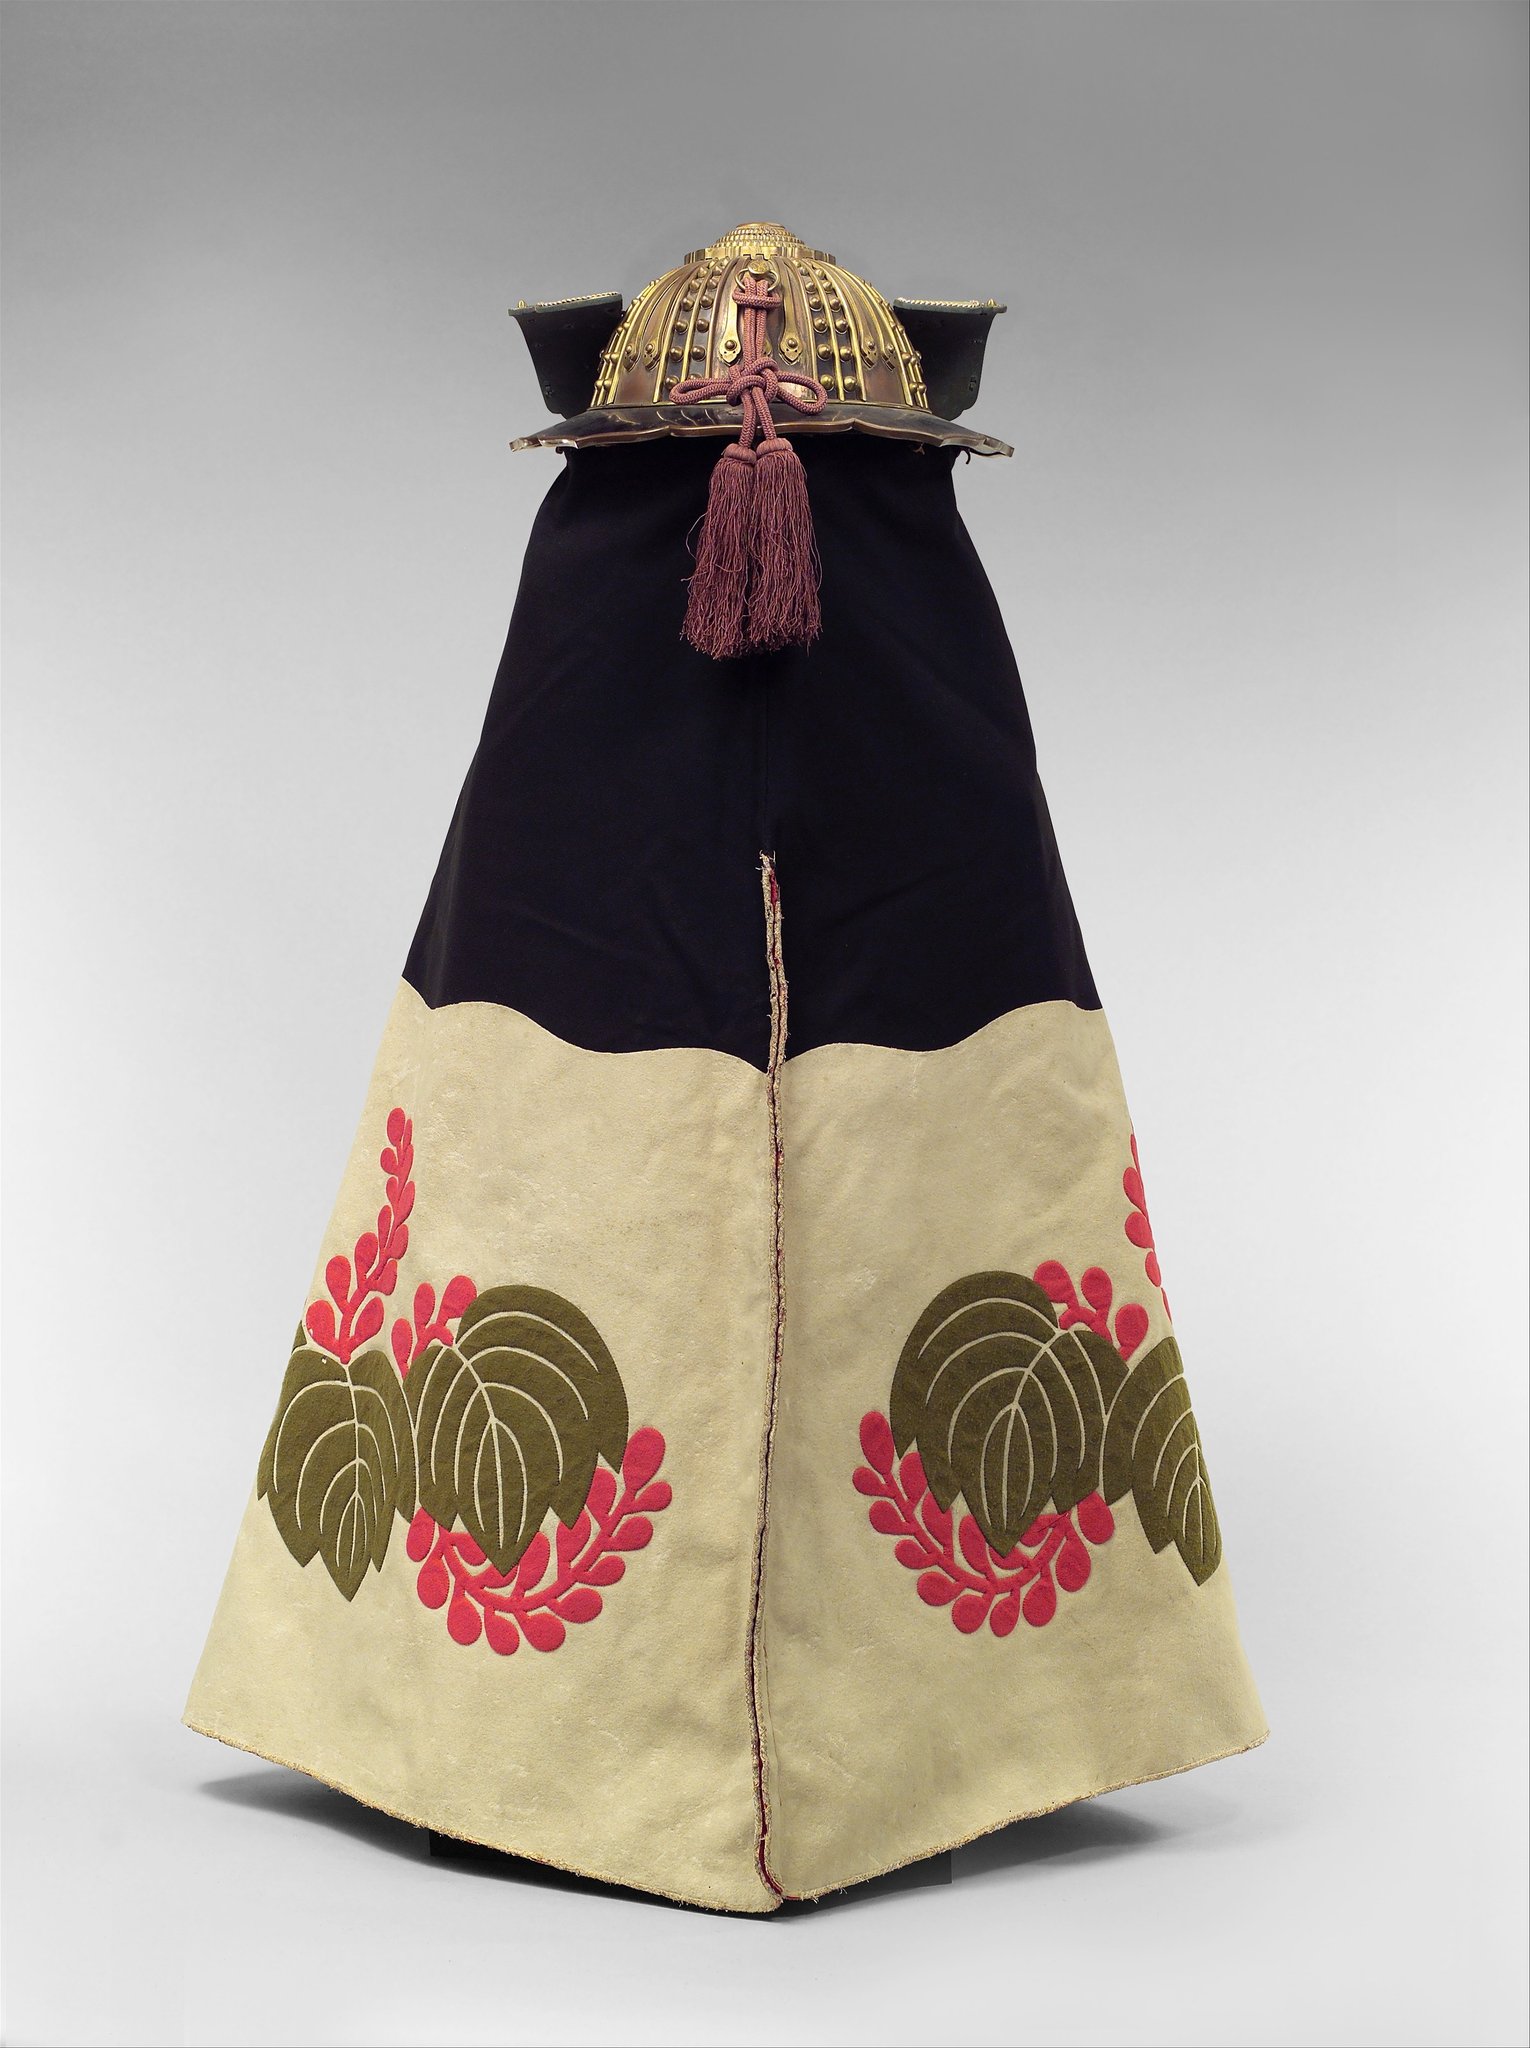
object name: fireman's helmet kajikabuto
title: Fireman's Helmet (Kajikabuto) for a Daimyo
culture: japanese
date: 1701-1800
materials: felt, copper gilt, lacquer, leather, silk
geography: japan